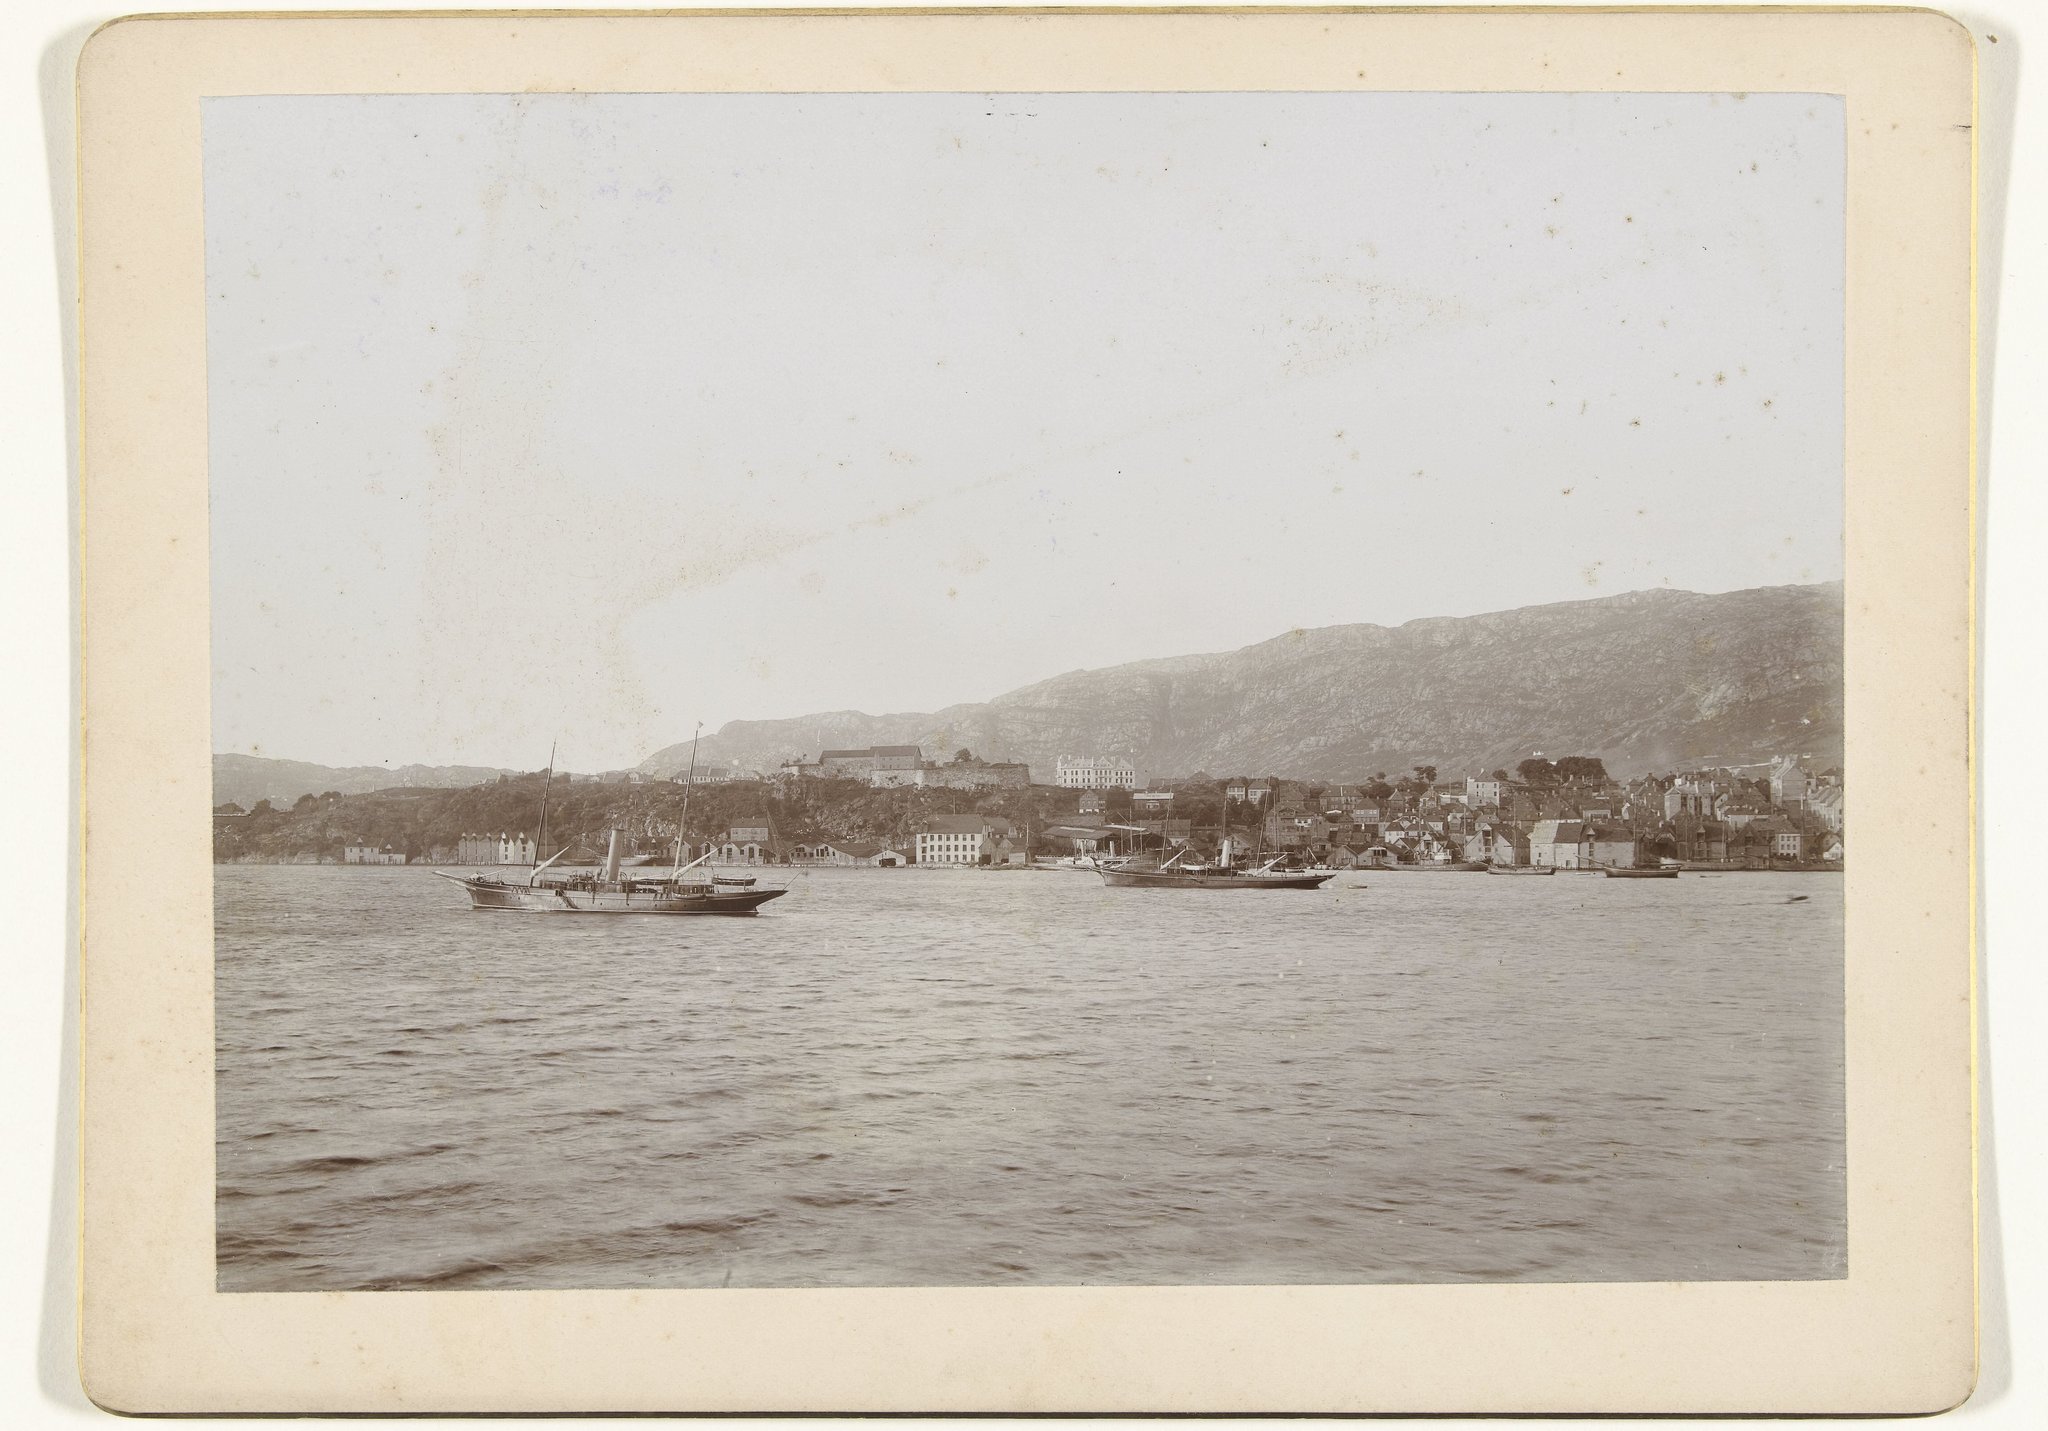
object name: photograph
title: Bergen gezien vanaf het water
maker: henry pauw van wieldrecht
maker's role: fotograaf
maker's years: 1863-1912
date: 1808-1896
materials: cardboard, photographic support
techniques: gelatin silver print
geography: bergen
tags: bergen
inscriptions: annotation: ‘No. 1221.’, signature and date: ‘H. Pauw v. Wieldrecht / photogr. Aug, 1896.’